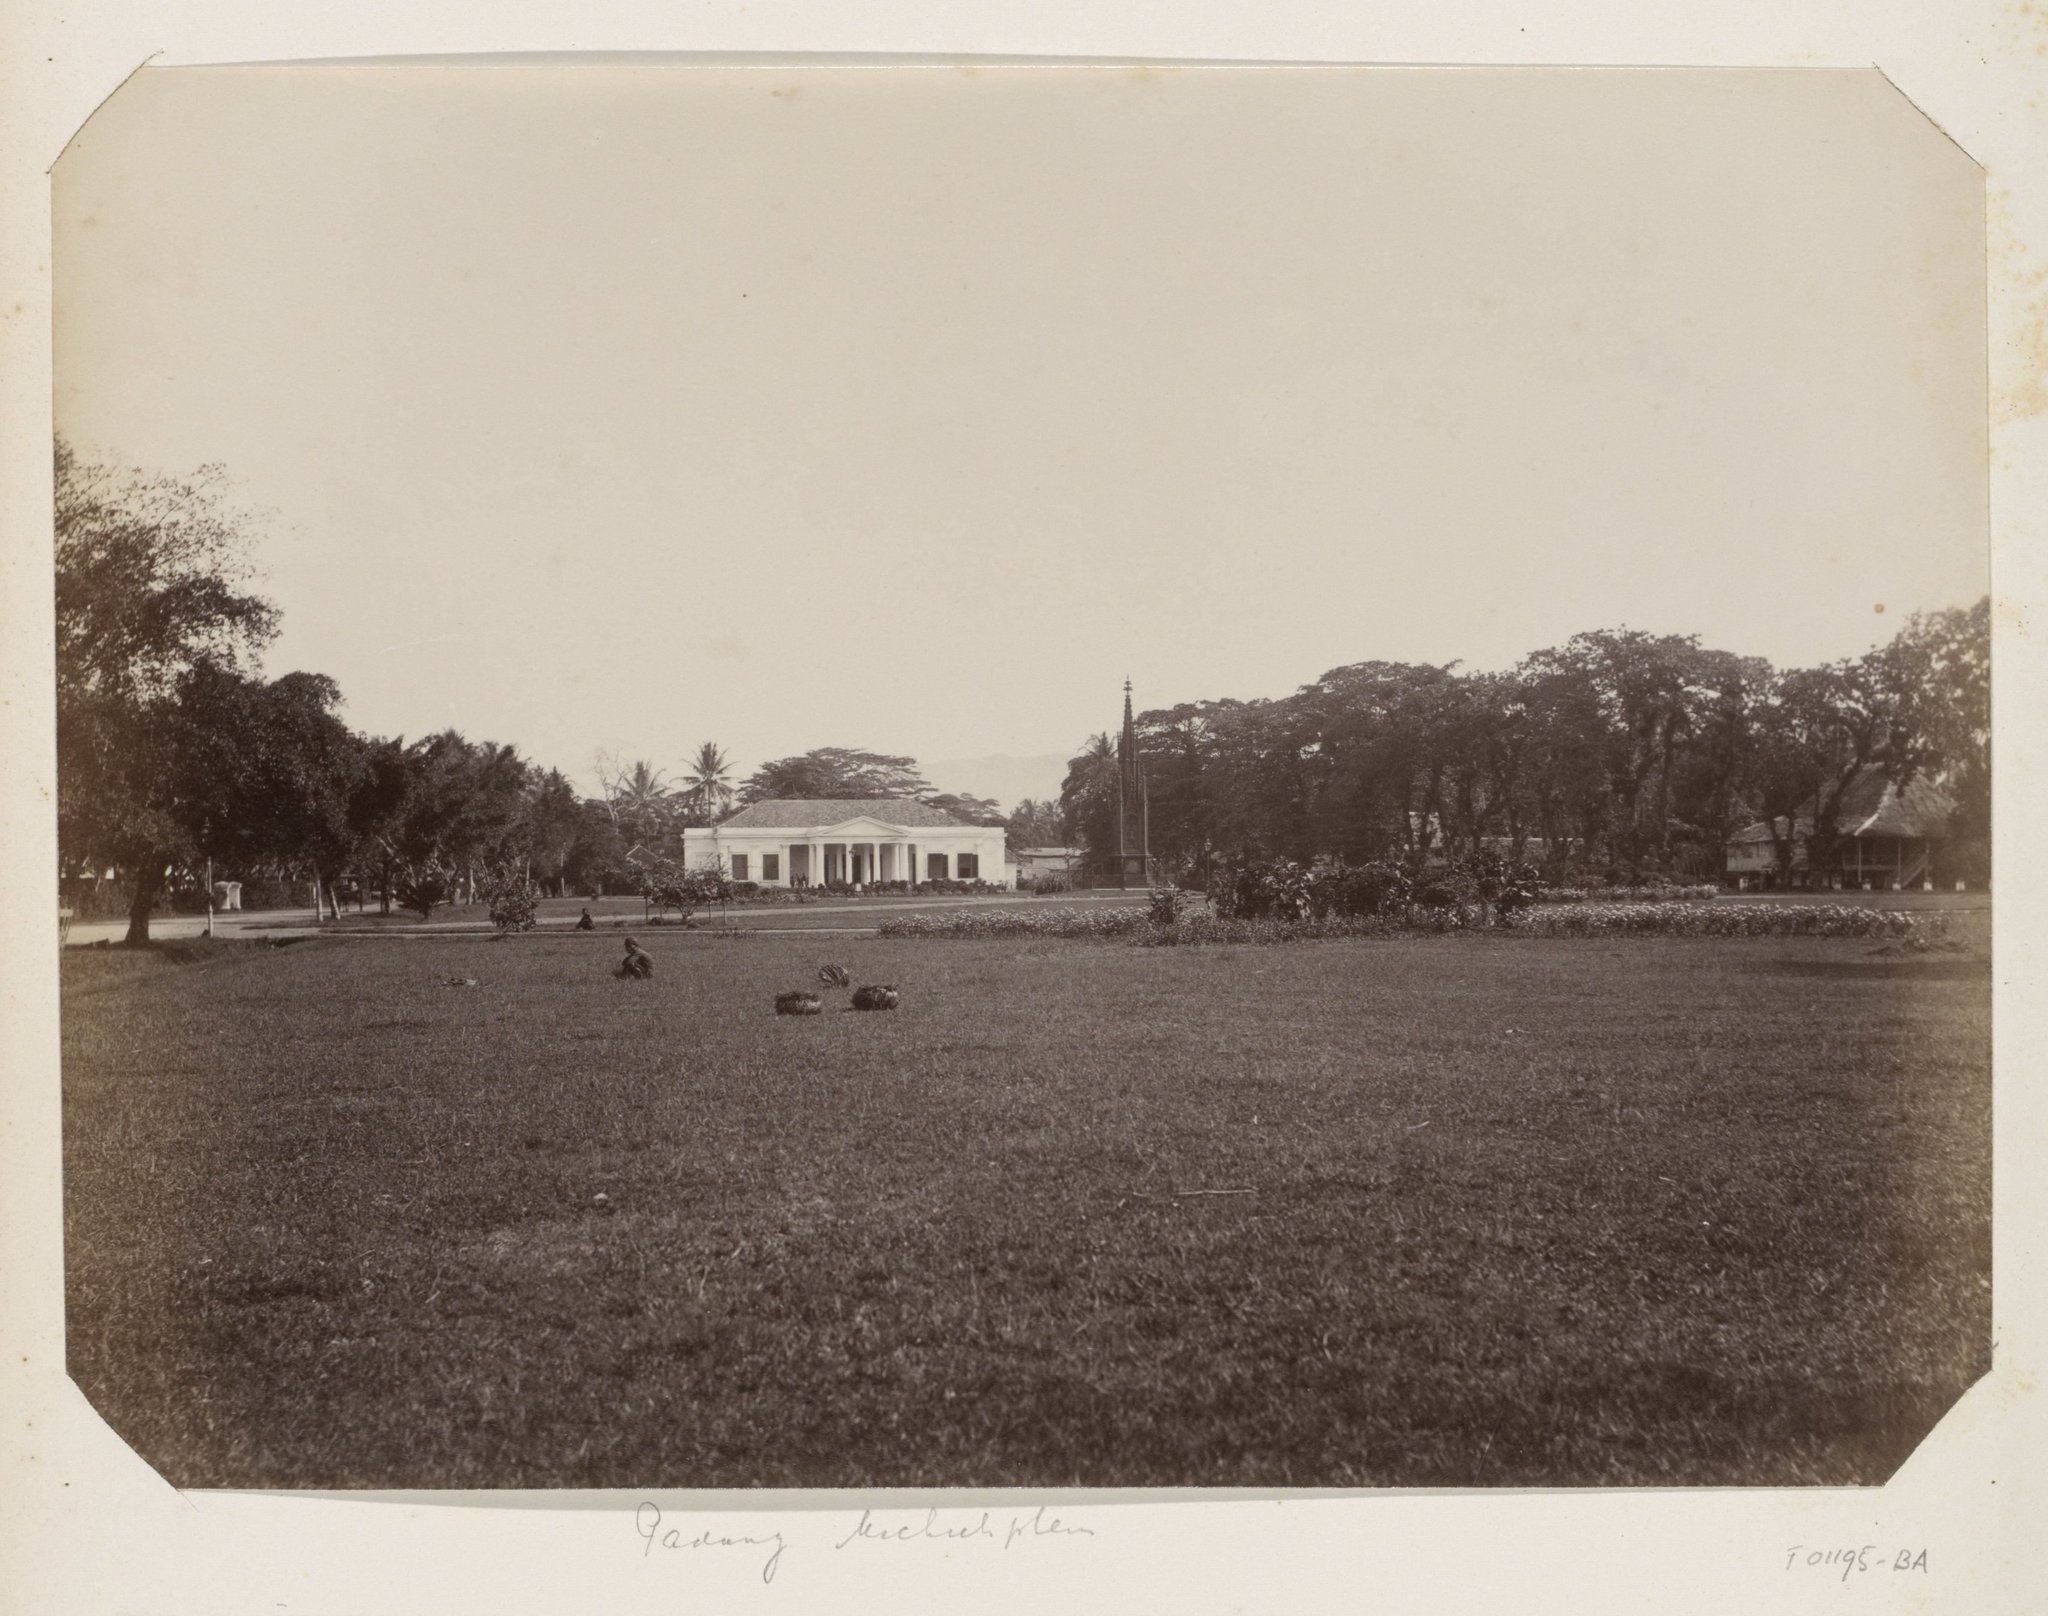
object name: photograph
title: Raadhuis en Michielsmonument aan het Michielsplein in Padang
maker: Anonymous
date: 1860-1900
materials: cardboard, paper, photographic support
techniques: albumen print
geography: padang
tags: townhall, monument, statue, square, place, circus, etc. (+ city(-scape) with figures, staffage), dutch east indies, the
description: Onderdeel van Fotoalbum van een reis door de Verenigde Staten, Honolulu, Nederlands-Indië, Aden, Zanzibar en Zuidelijk Afrika.